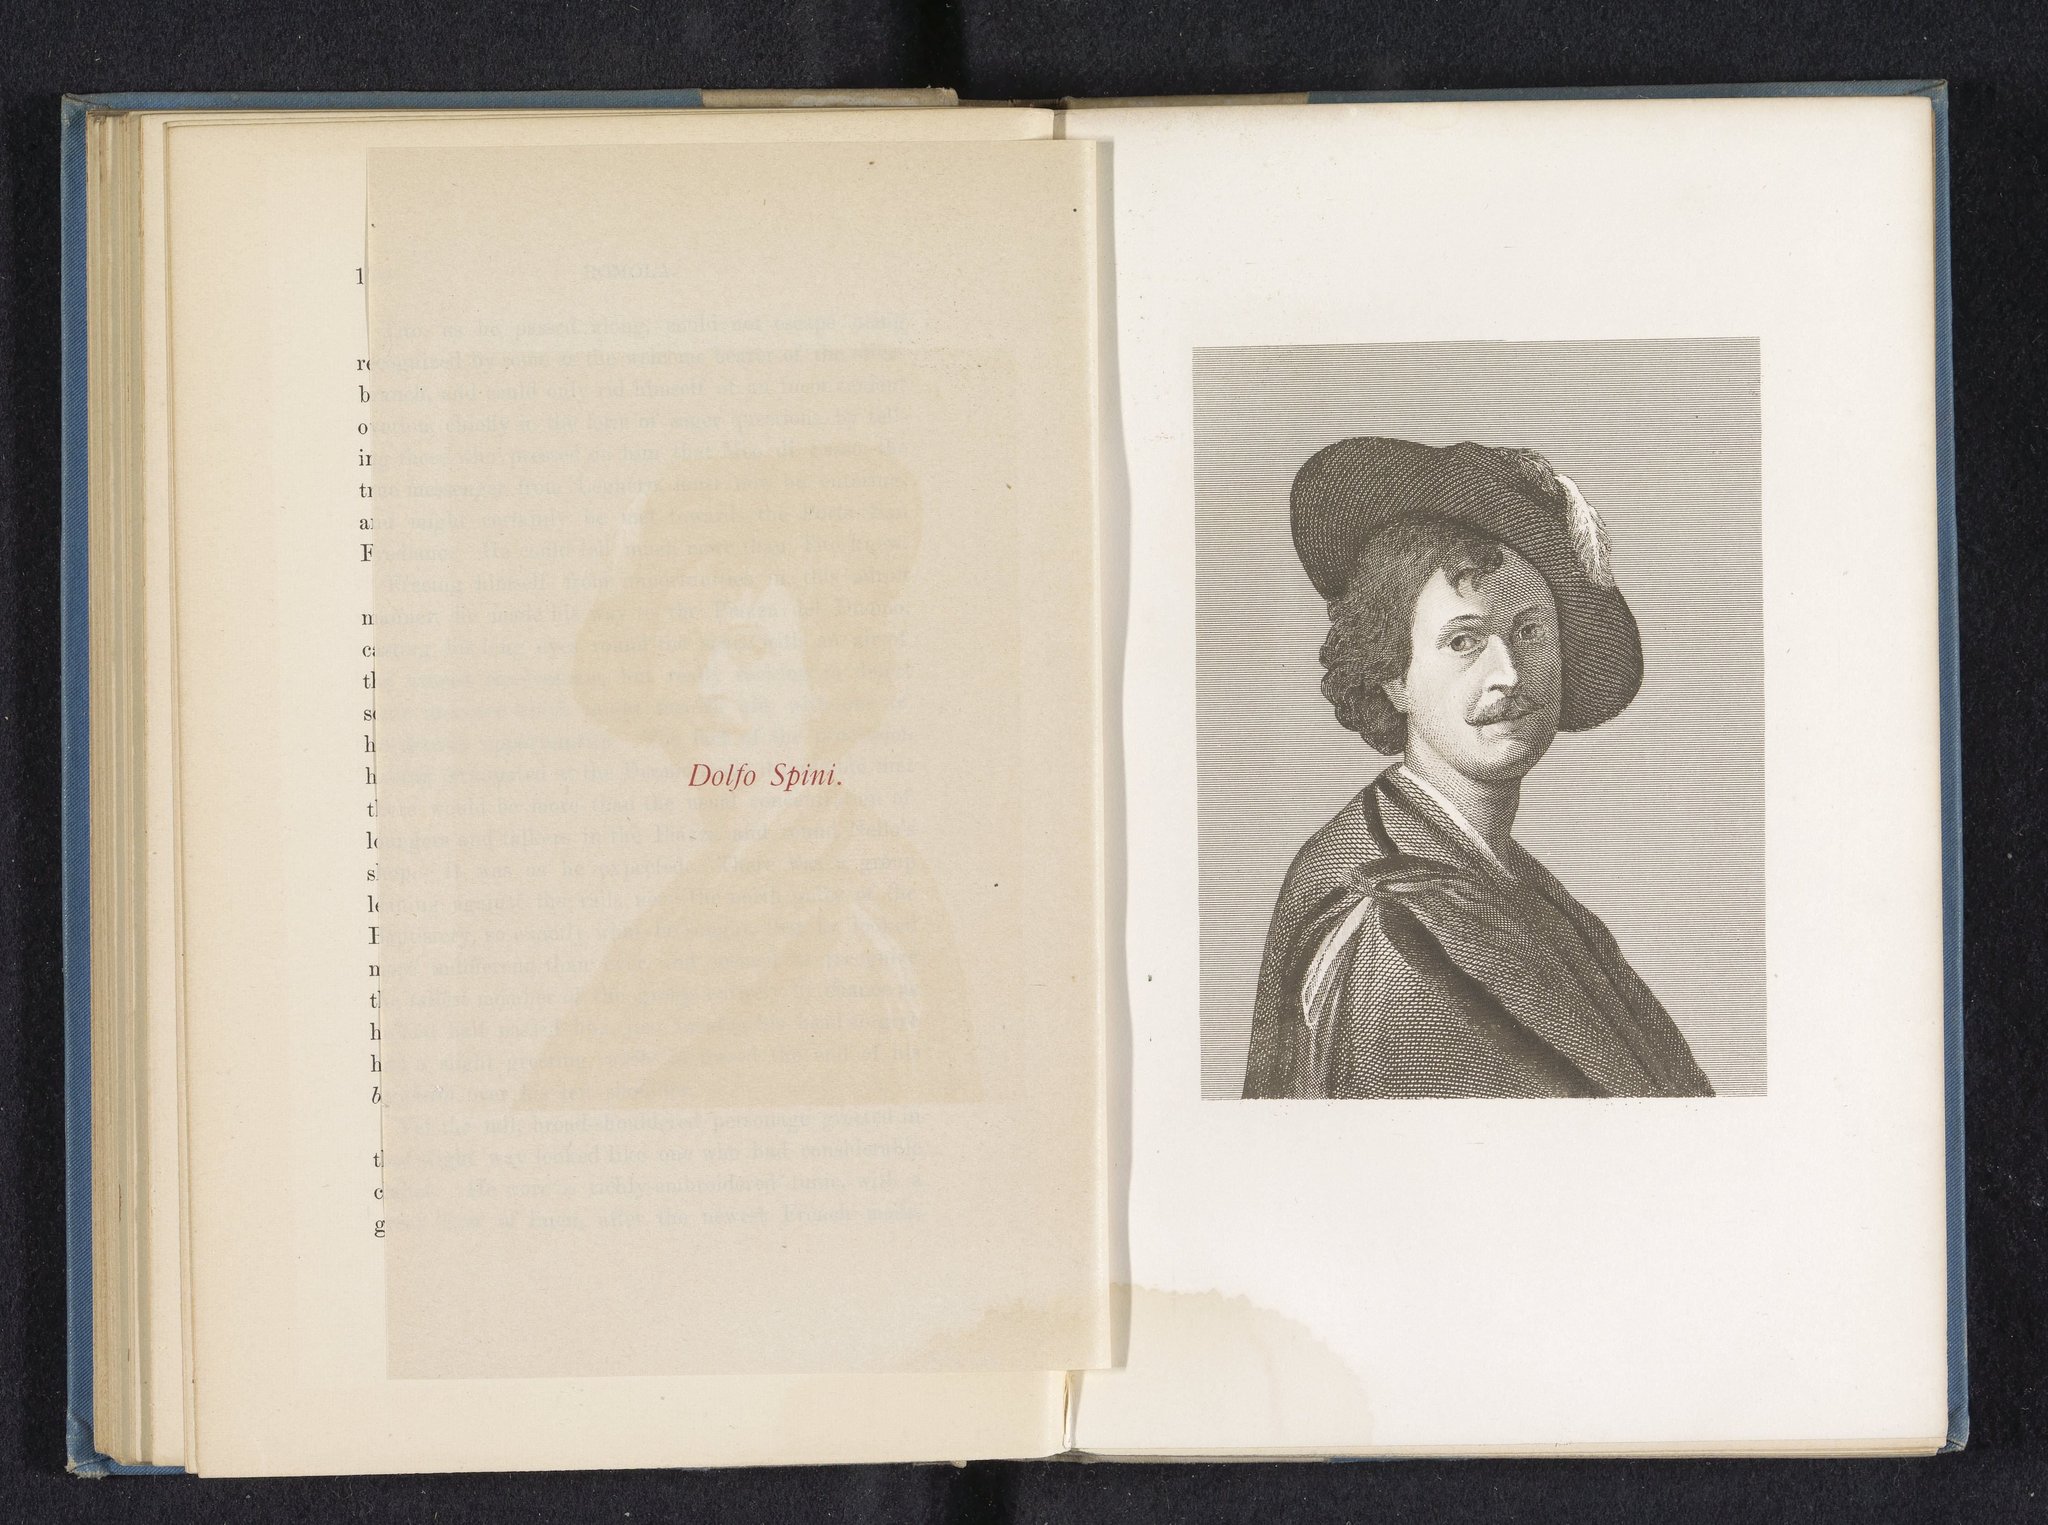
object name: photomechanical print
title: Fotoreproductie van een prent, voorstellende een portret van Dolfo Spini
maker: Anonymous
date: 1880-1890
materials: paper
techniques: photoaquatint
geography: florence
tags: revolutionary committee, rebel group, adult man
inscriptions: title: ‘Dolfo Spini.’